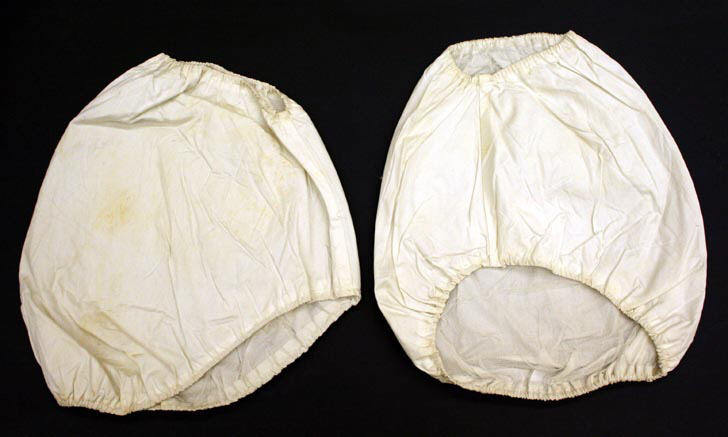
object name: sleeve support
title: Sleeve supports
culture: american or european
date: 1867-1900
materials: cotton